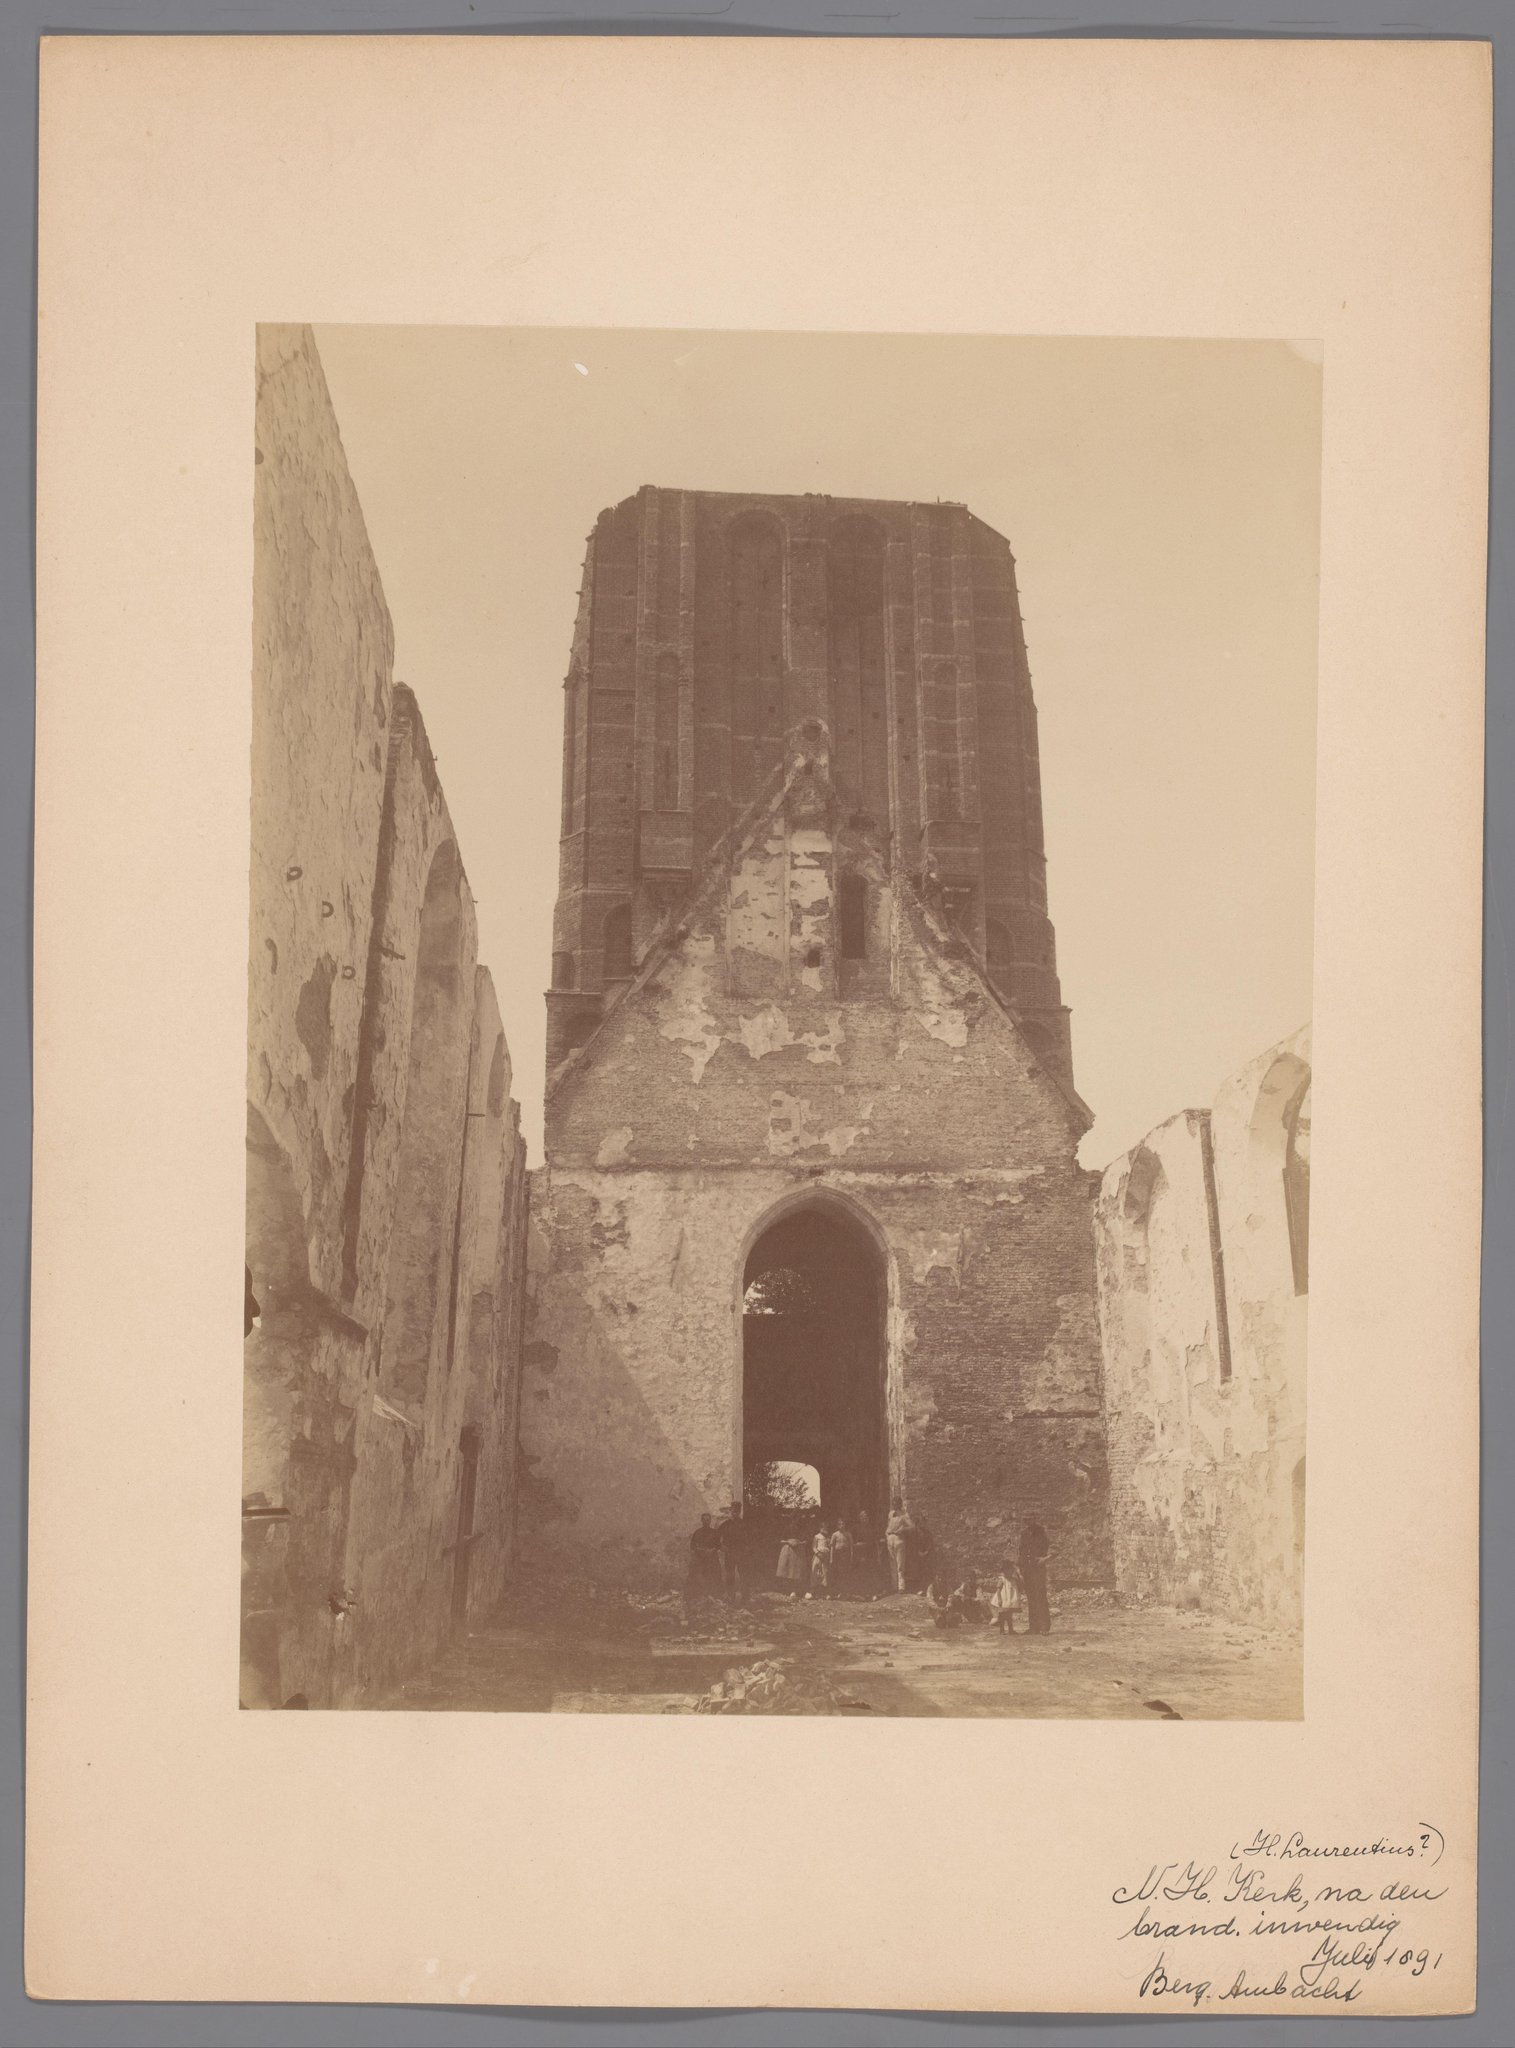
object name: photograph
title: Groepsportret van een onbekend gezelschap in de Grote of st. Laurentiuskerk te Bergambacht na de brand van 1891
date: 1891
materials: cardboard, photographic support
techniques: albumen print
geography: bergambacht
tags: interior of church, tower (of house or building), anonymous historical persons portrayed in a group, in a group-portrait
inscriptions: annotation: ‘Berg-ambacht/ N.H. kerk inwendig (na den brand)/ juli 1891’, annotation: ‘(H. Laurentius?)/ N.H. Kerk, na den brand. inwendig/ juli 1891/ Berg. Ambacht’